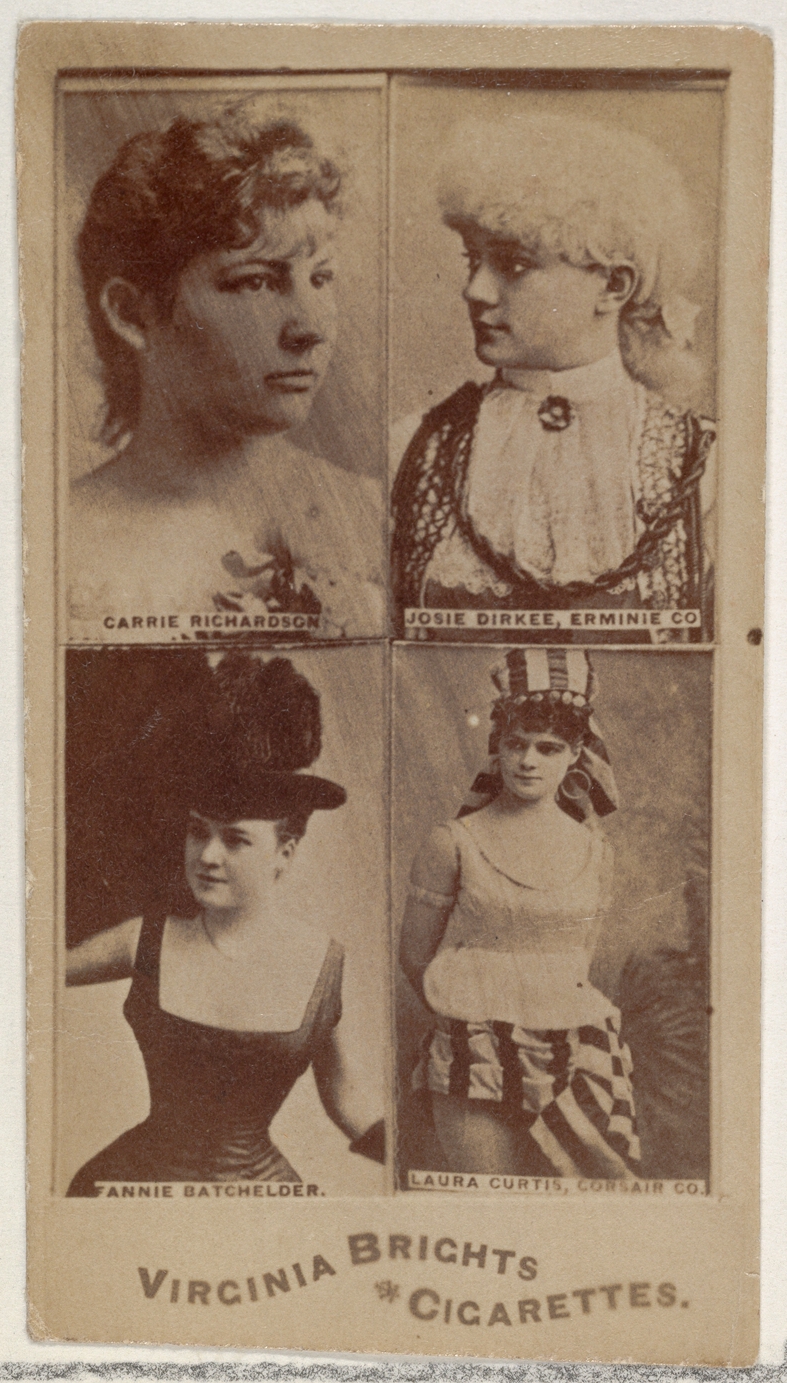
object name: photograph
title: Carrie Richardson/ Josie Dirkee, Erminie Co./ Fannie Batchelder/ Laura Curtis, Corsair Co., from the Actors and Actresses series (N45, Type 4) for Virginia Brights Cigarettes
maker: allen & ginter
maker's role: publisher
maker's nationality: american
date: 1888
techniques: albumen silver print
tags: portraits,women,actresses